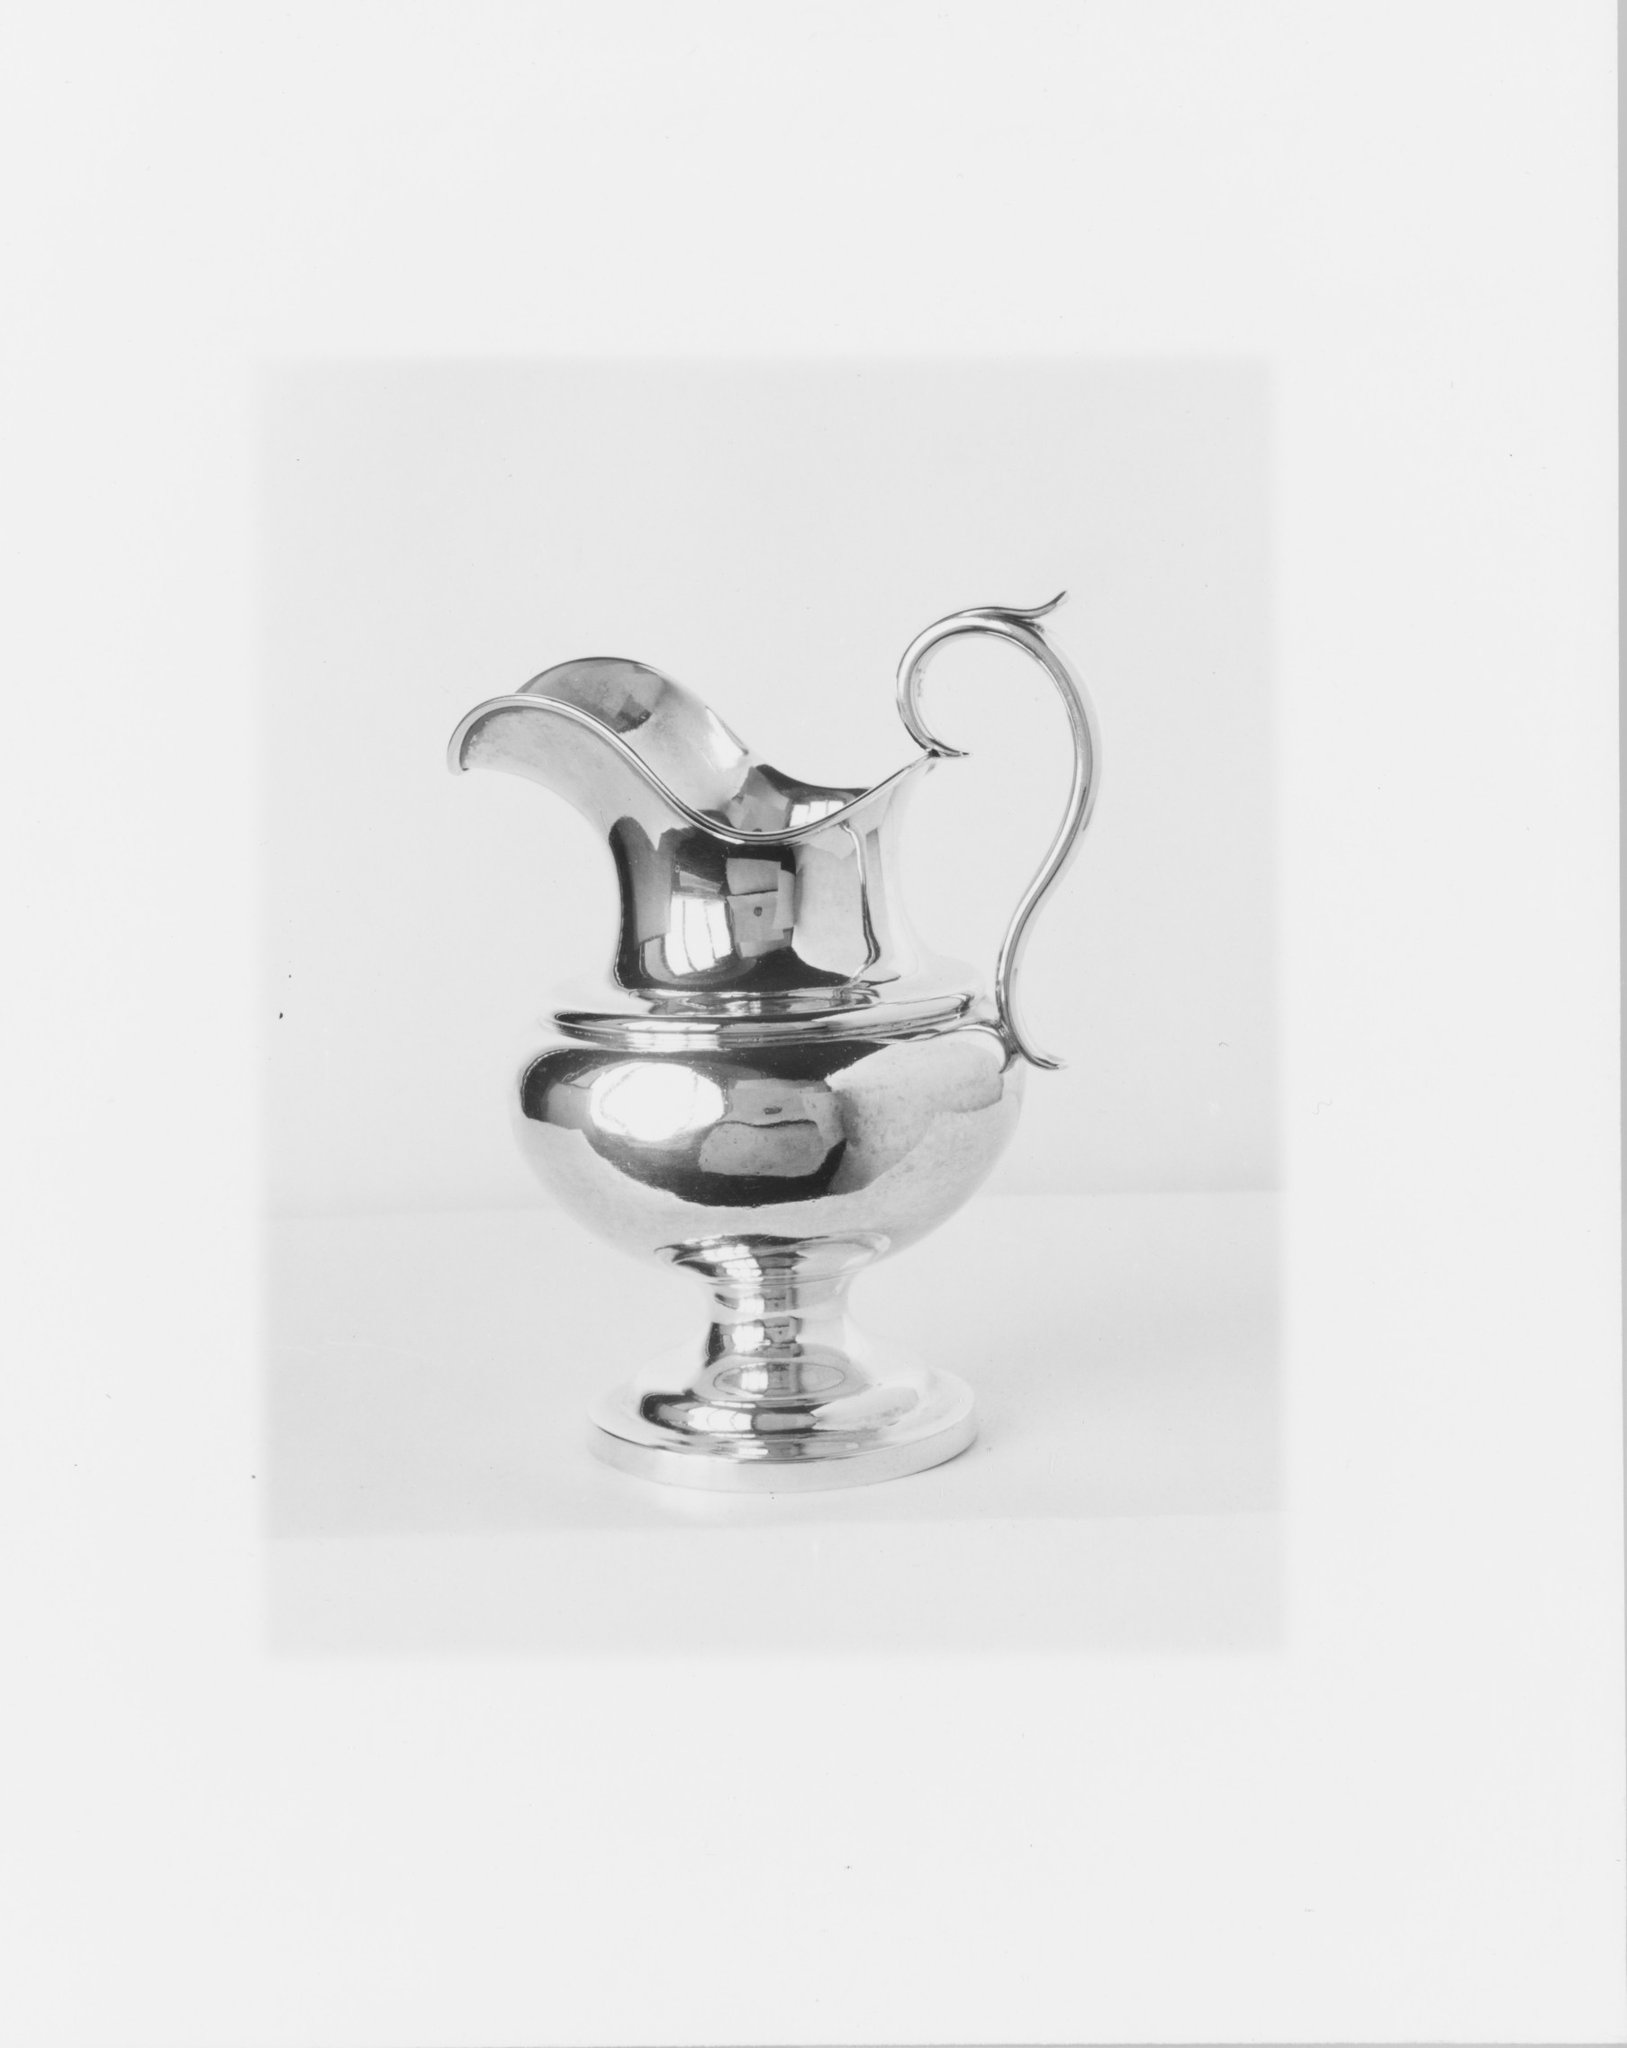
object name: cream pot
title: Creamer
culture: american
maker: newell harding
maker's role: maker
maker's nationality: american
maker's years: 1796-1862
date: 1830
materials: silver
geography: united states